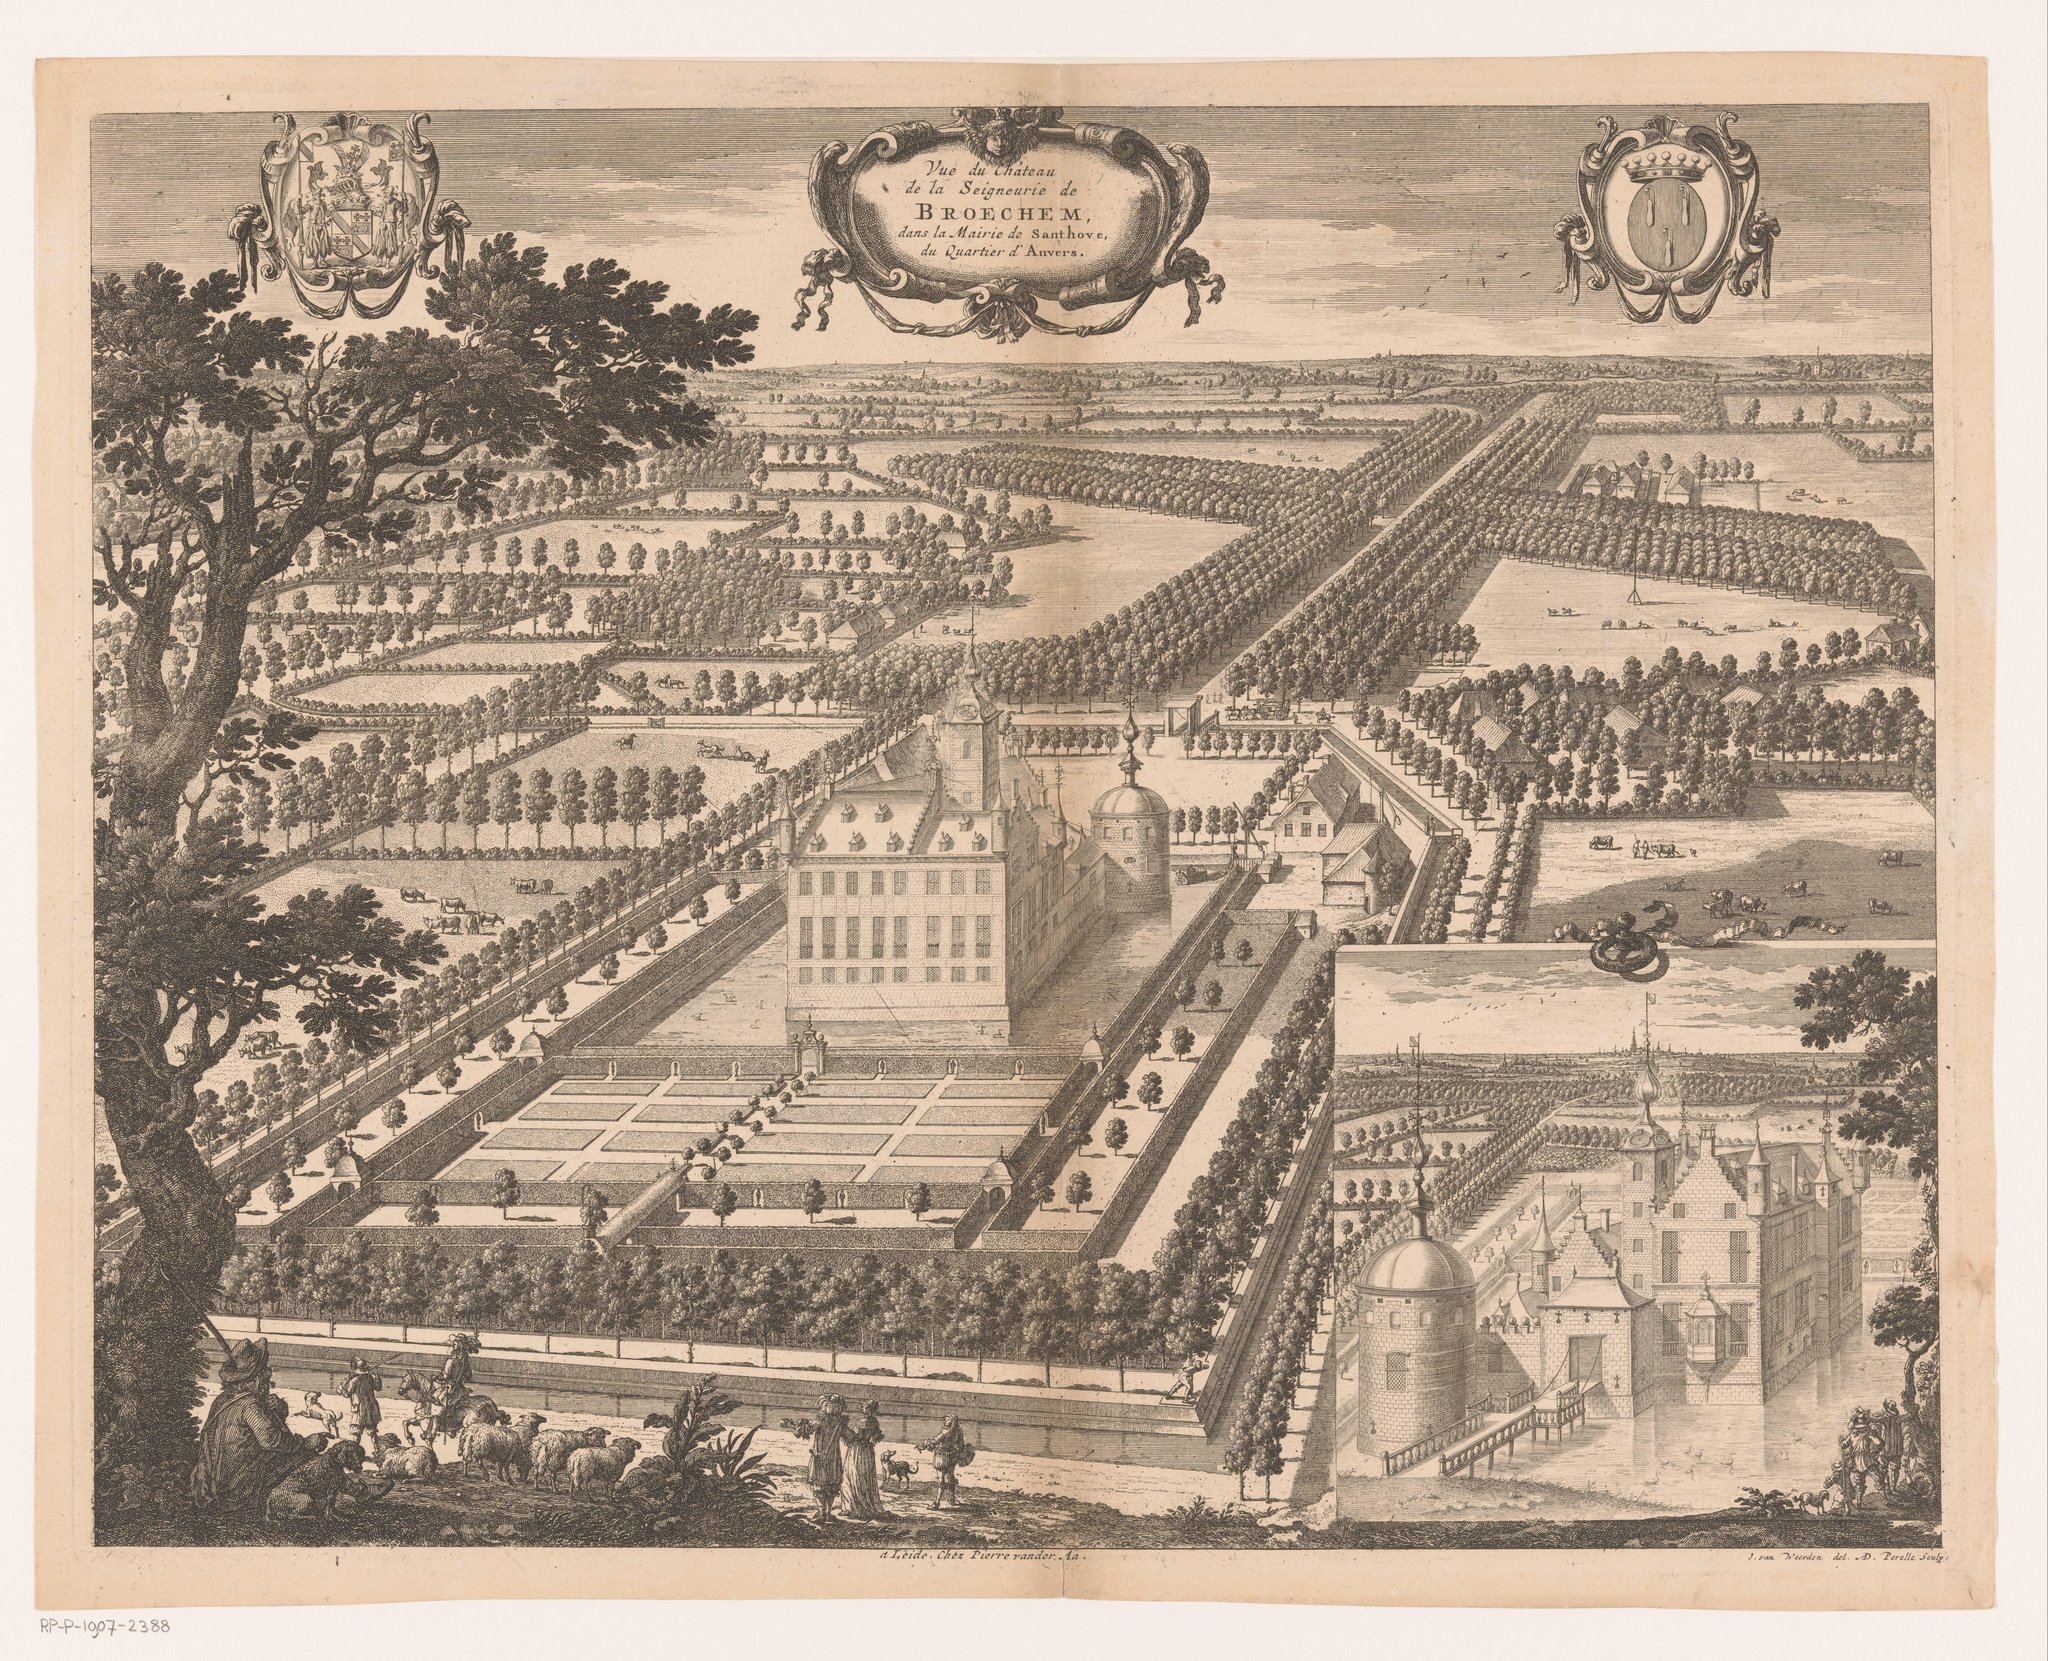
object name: print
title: Gezicht op het landgoed van kasteel Broechem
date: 1669-1695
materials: paper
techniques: engraving, etching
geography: leiden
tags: castle, landscape with tower or castle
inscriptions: collector's mark: Lugt 2228